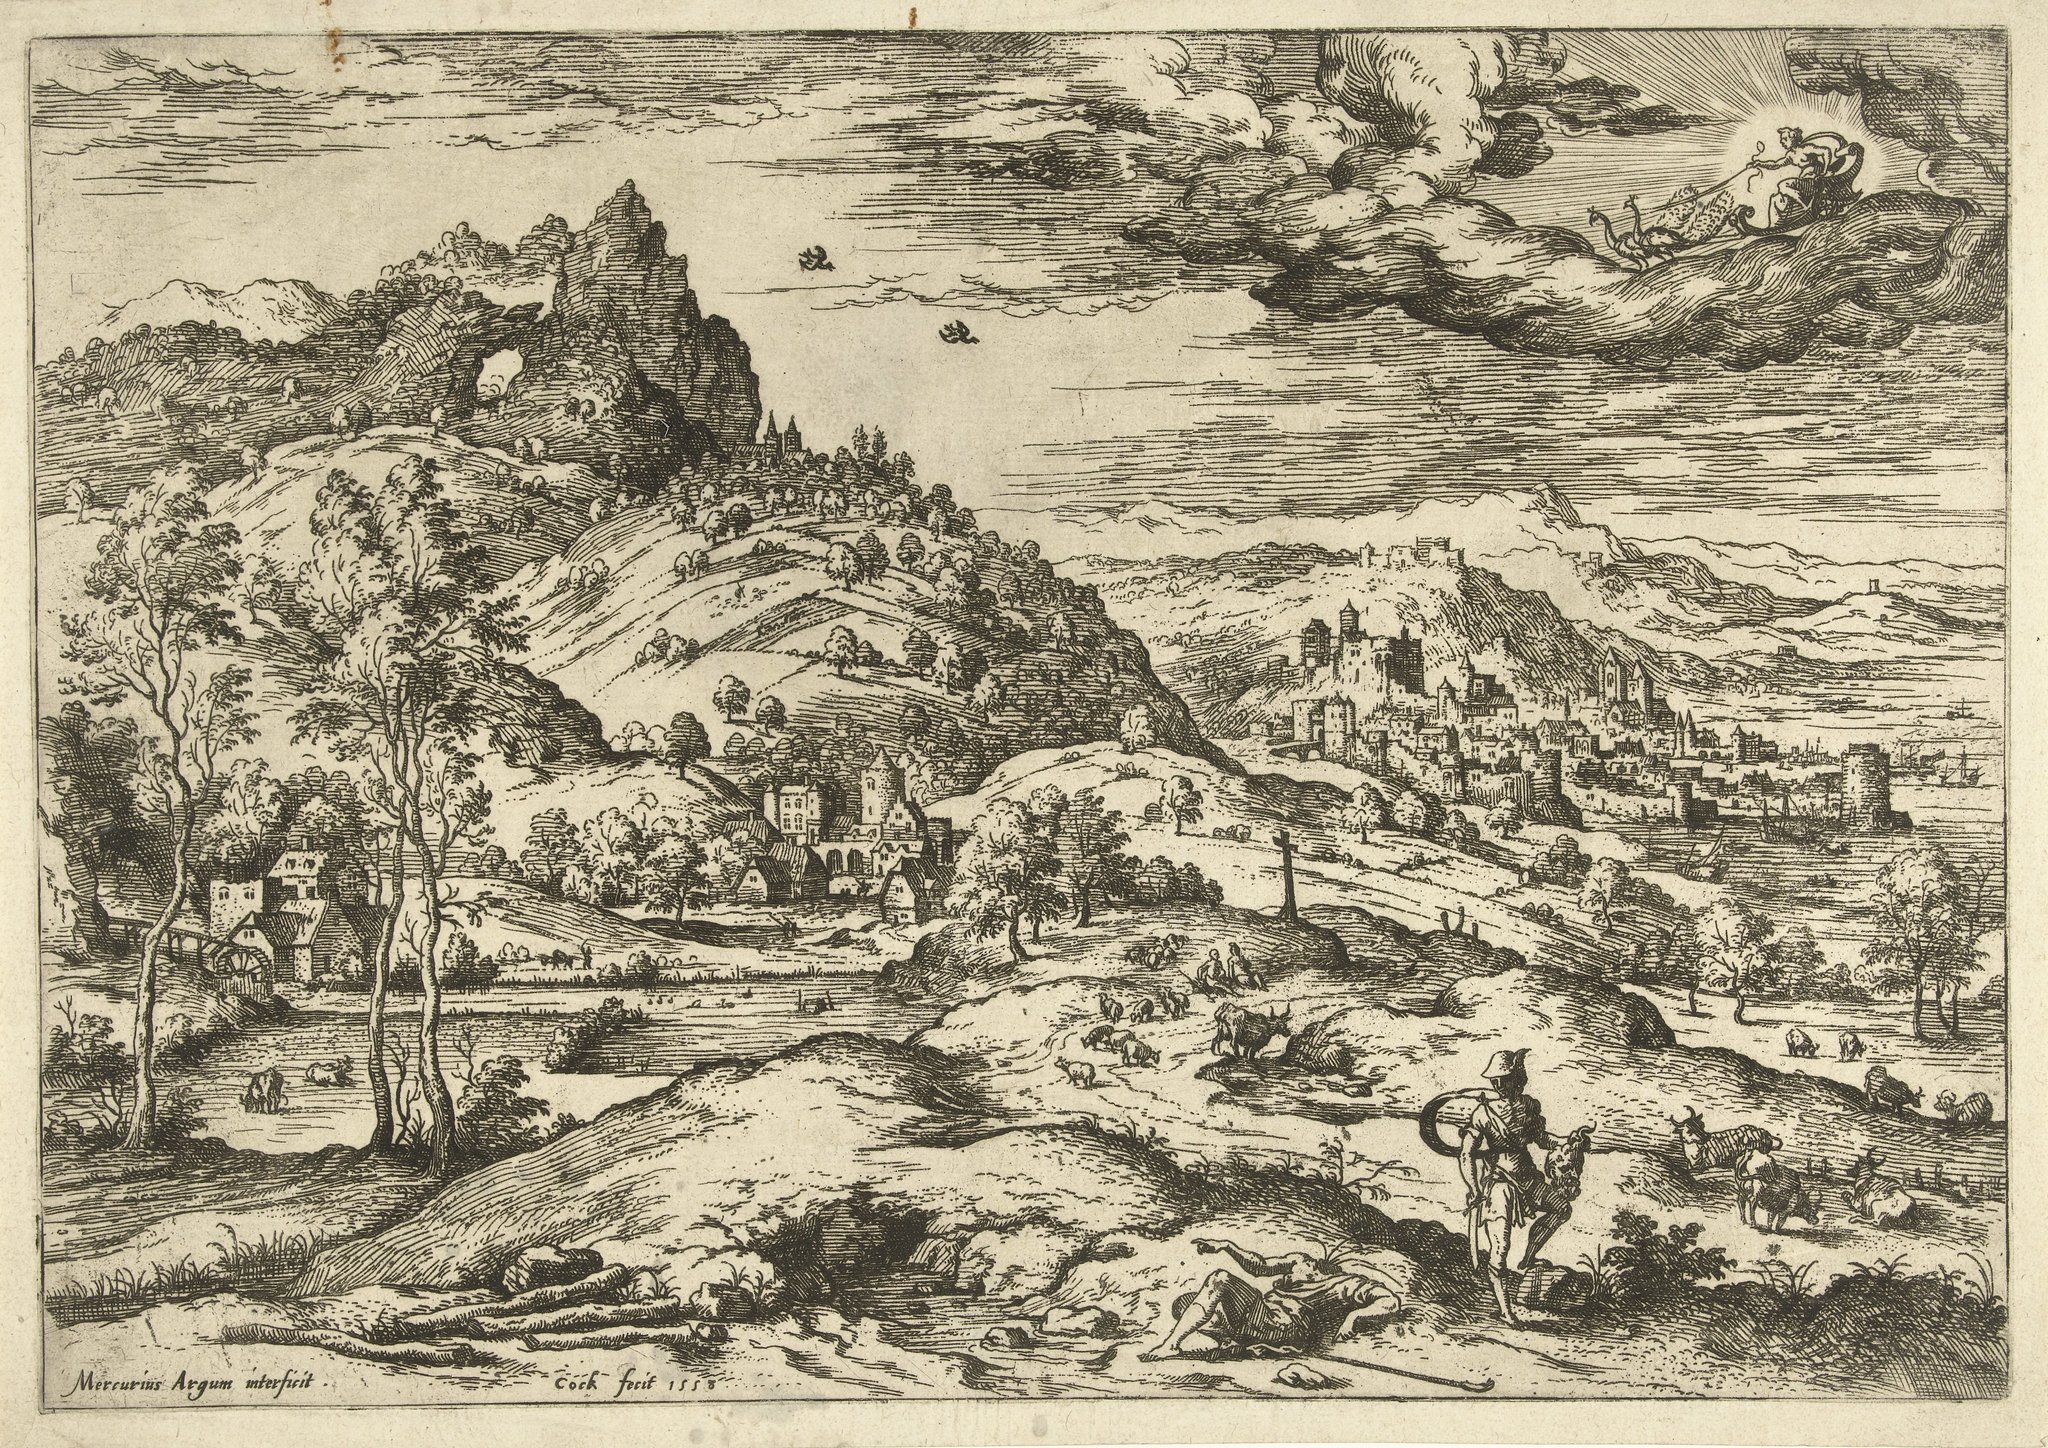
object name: print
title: Landschappen met bijbelse en mythologische scènes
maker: hieronymus cock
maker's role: print maker, publisher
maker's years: 1518-1570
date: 1558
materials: paper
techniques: etching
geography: antwerp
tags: (story of) mercury (hermes), mercury beheads argus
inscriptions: collector's mark: Lugt 2228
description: Heuvelachtig landschap met een havenstadje in de verte. Rechts voor Mercurius die de reus Argus het hoofd afgehakt heeft. Mercurius houdt het hoofd in zijn hand. In de wolken rijdt Juno in haar koets die getrokken wordt door twee pauwen. Prent uit een serie van 13 landschappen met bijbelse en mythologische scènes.